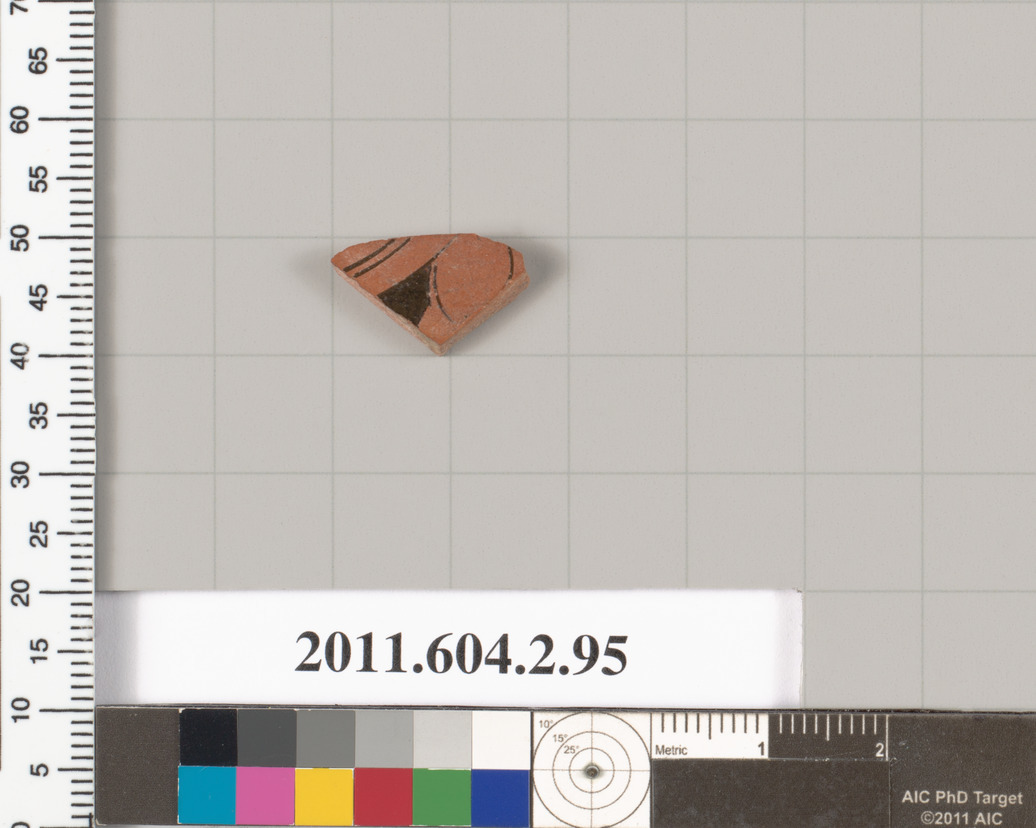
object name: pelike fragment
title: Terracotta fragment of a pelike (jar)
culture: greek, attic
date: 490-480 BCE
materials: terracotta